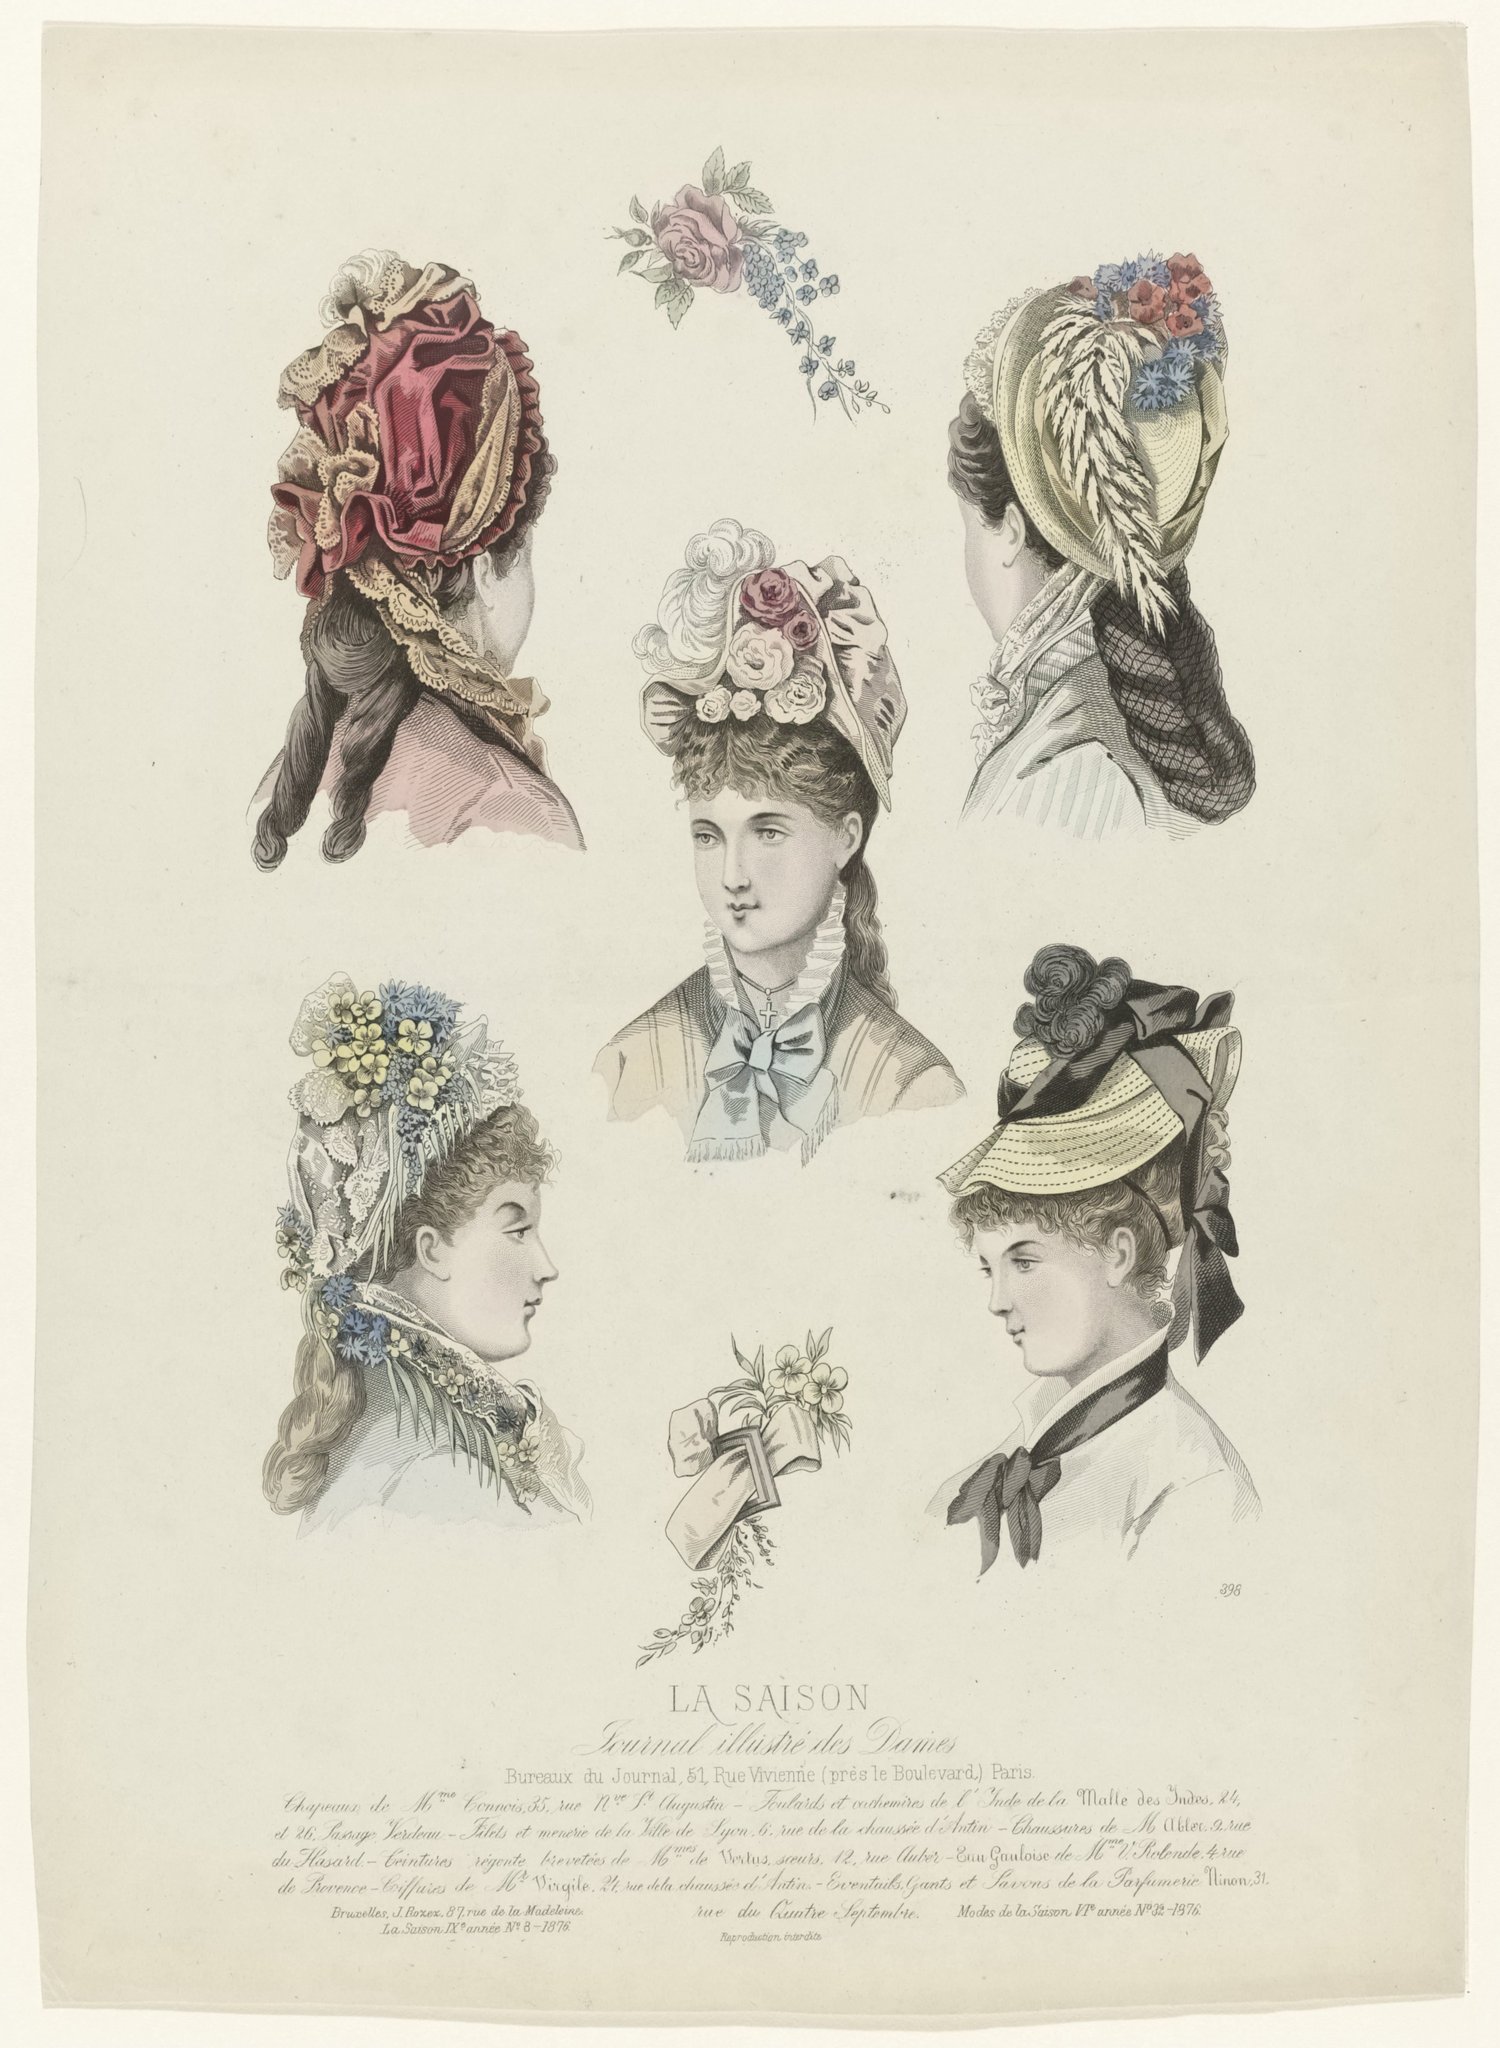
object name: fashion print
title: La Saison, Journal illustré des Dames, 1876, 9e année, No. 8, No. 398: Chapeaux de Mme Connois (...)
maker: Anonymous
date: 1880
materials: paper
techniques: engraving, hand coloring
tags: cut flowers; nosegay, bunch of flowers, border, ribbon, braid (+ women's clothes), fashion plates, head-gear: hat (+ women's clothes)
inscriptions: address: ‘Bureaux du Journal, 51, Rue Vivienne (près le Boulevard,) Paris.’, title: ‘LA SAISON / Journal illustré des Dames’, address: ‘Bruxelles, J. Rozez, 87, rue de la Madeleine. La Saison, IXe année No. 8 - 1876 / Modes de la Saison, VIe année No. 31- 1876.’, caption: ‘Chapeaux de Mme Connois, 35, rue Nve St Augustin - Foulards et cachemires de l'Inde de la Malle des Indes, 24, et 26, Passage Verdeau - Filets et menerie de la Ville de Lyon, 6, rue de la chaussée d'Antin - Chaussures de M. Abler, 9, rue du hasard . - ceintures régente brevetées de Mmes de Vertus soeurs, 12, rue Auber - Eau Gauloise de Mme V. Rolende, 4, rue de Provence - Coiffures de Mr Virgile, 24, rue de la chaussée d'Antin . - Eventails, Gants et Savons de la Parfumerie Ninon, 31, rue du Quatre-Septembre.’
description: Vijf modellen van hoeden van Connois. In onderschrift enkele regels reclametekst voor verschillende producten. Prent uit de modetijdschriften(?) La Saison (1867-1902) en Les Modes de la Saison (1871-1885).